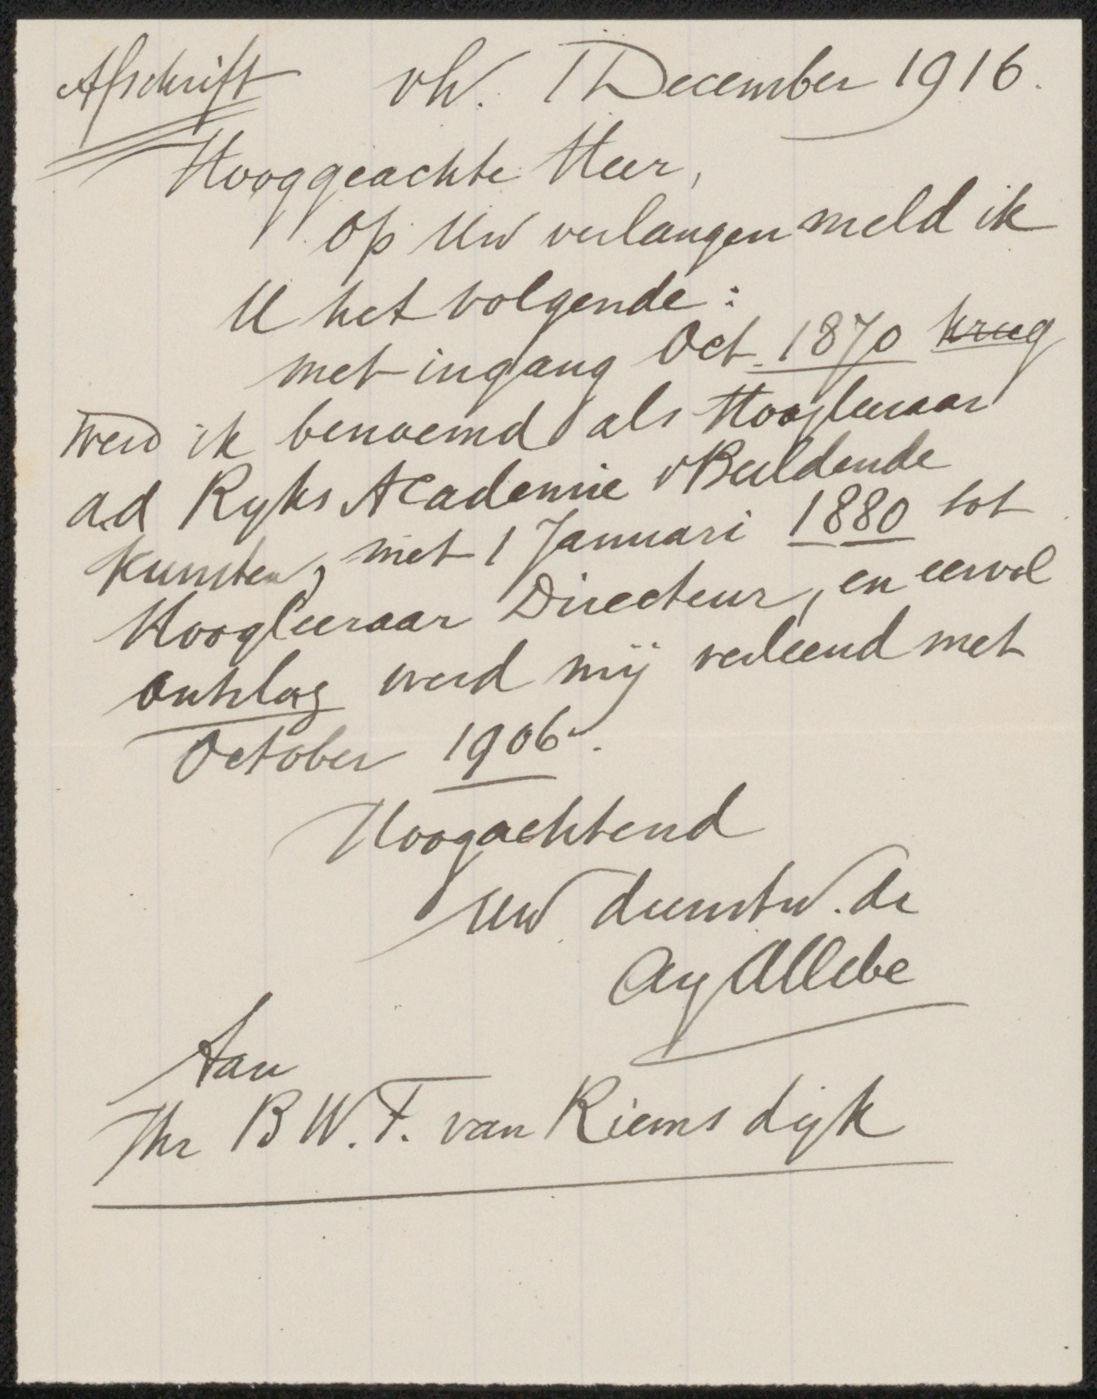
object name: letter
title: Brief aan jonkheer Barthold Willem Floris van Riemsdijk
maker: august allebé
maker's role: draughtsman, print maker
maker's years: 1838-1927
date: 1916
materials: ink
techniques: pen, writing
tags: maastricht, amsterdam, print maker, engineer, jonkheer barthold willem floris van riemsdijk